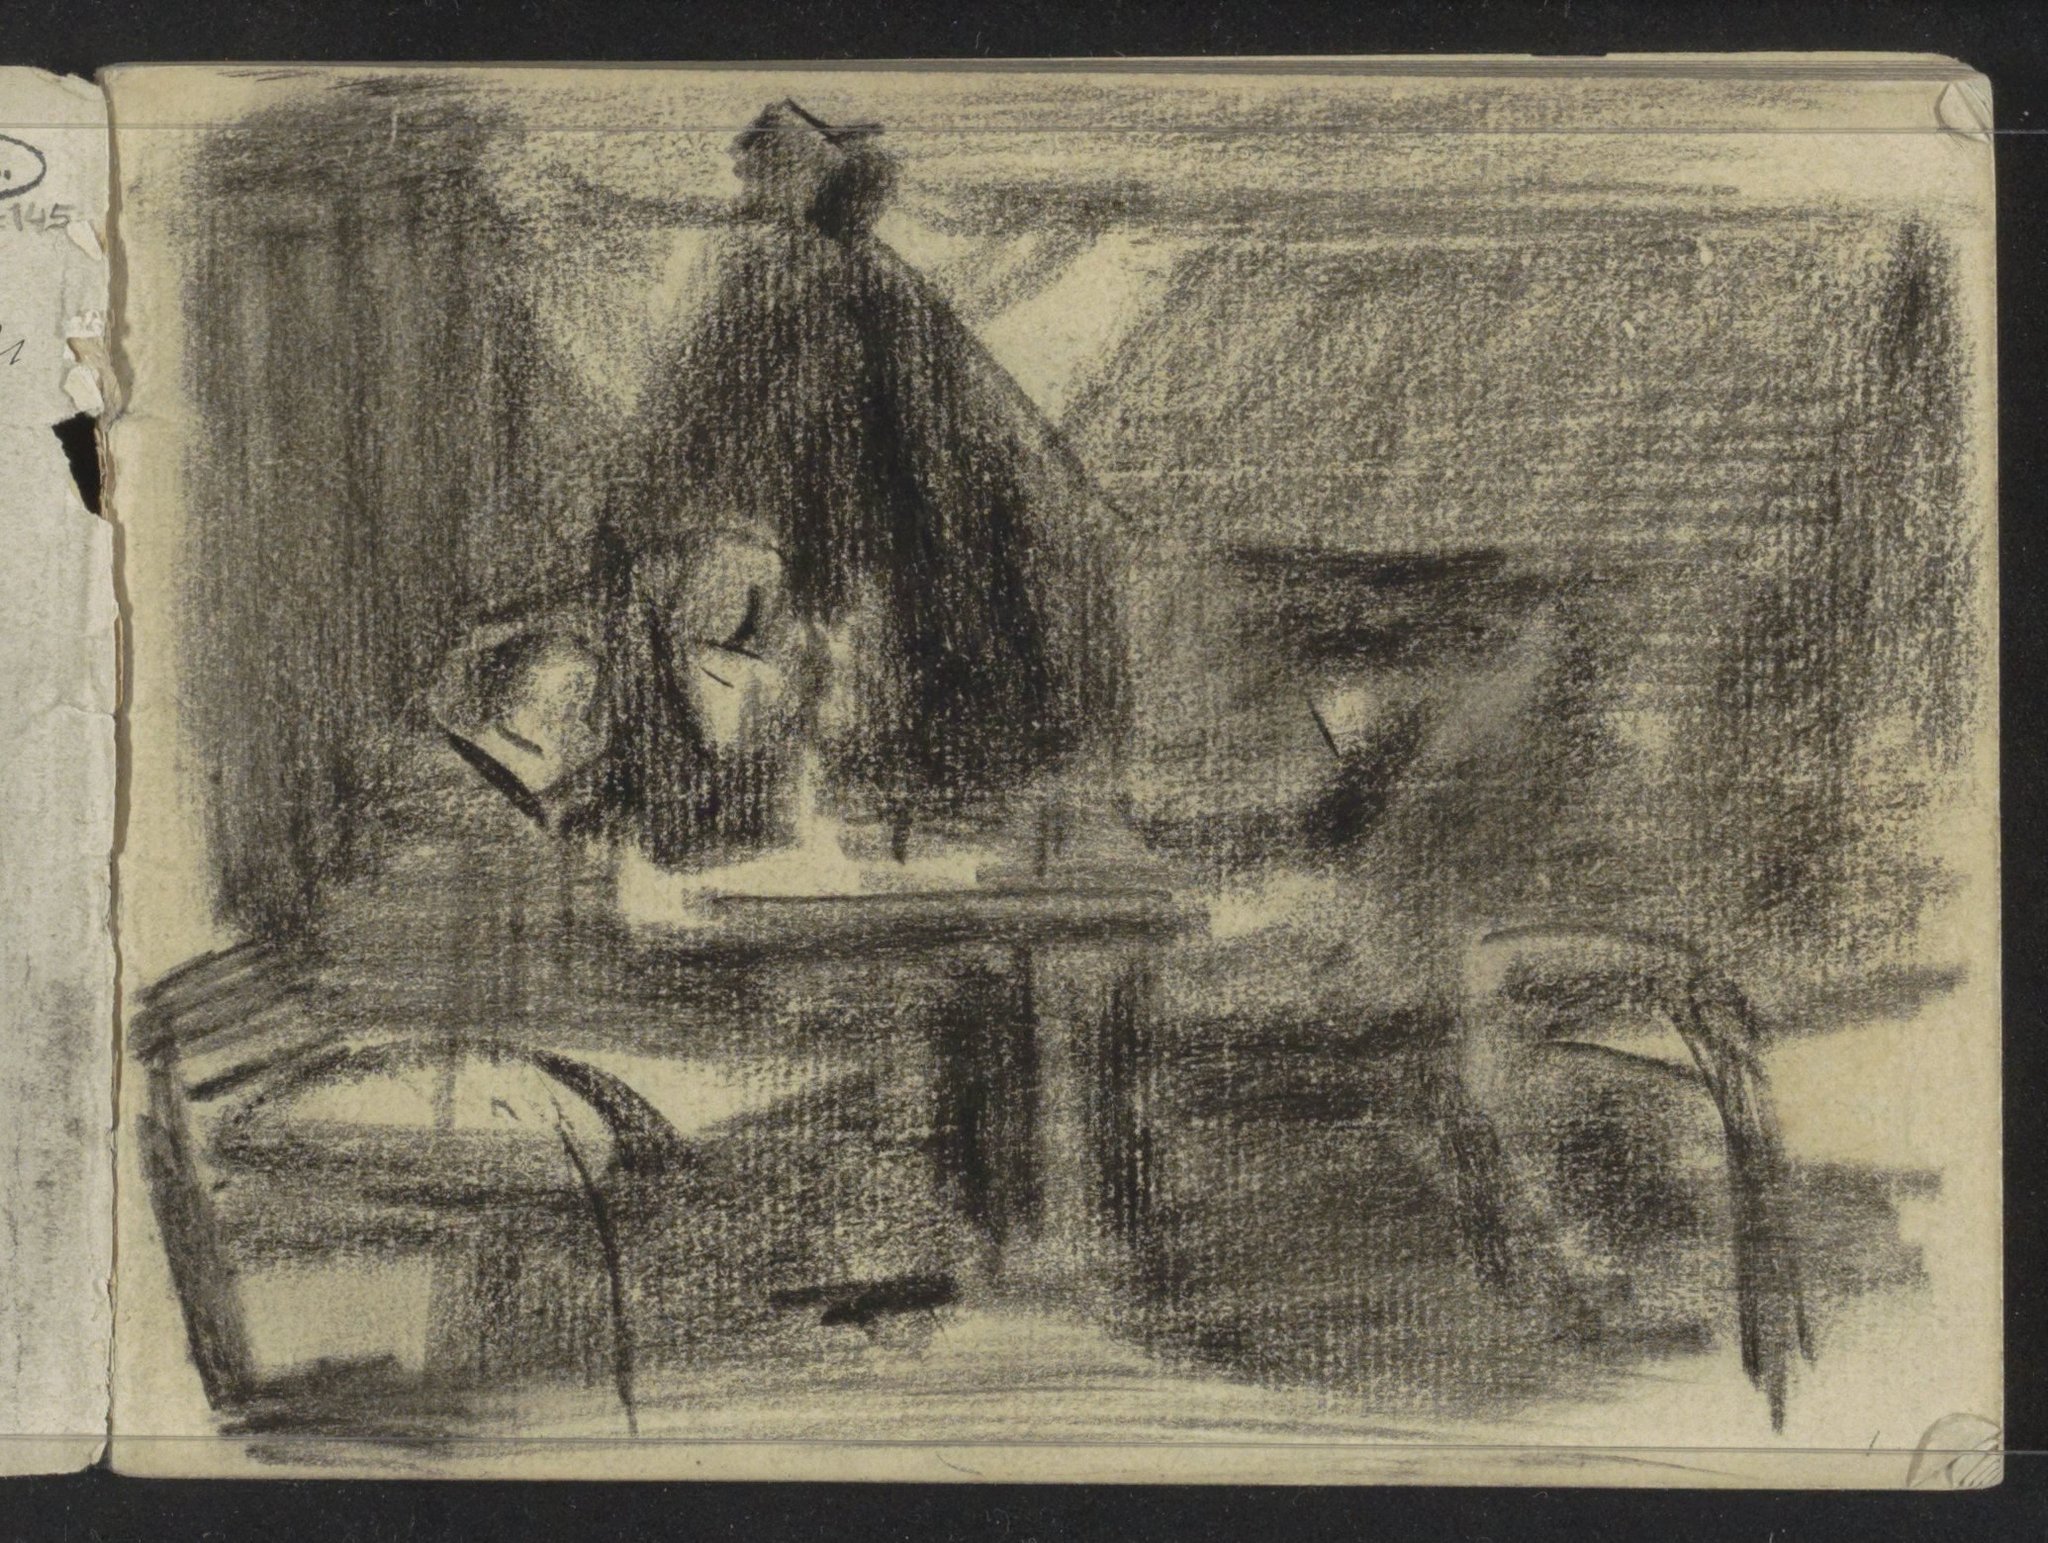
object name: sketchbook leaf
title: Figuren aan een tafel in een interieur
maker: isaac israels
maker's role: draughtsman, painter, print maker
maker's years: 1865-1934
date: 1886-1934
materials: chalk, paper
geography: amsterdam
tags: sitting figure, table, interior of the house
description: Blad 1 recto uit schetsboek LXIV met 29 bladen.